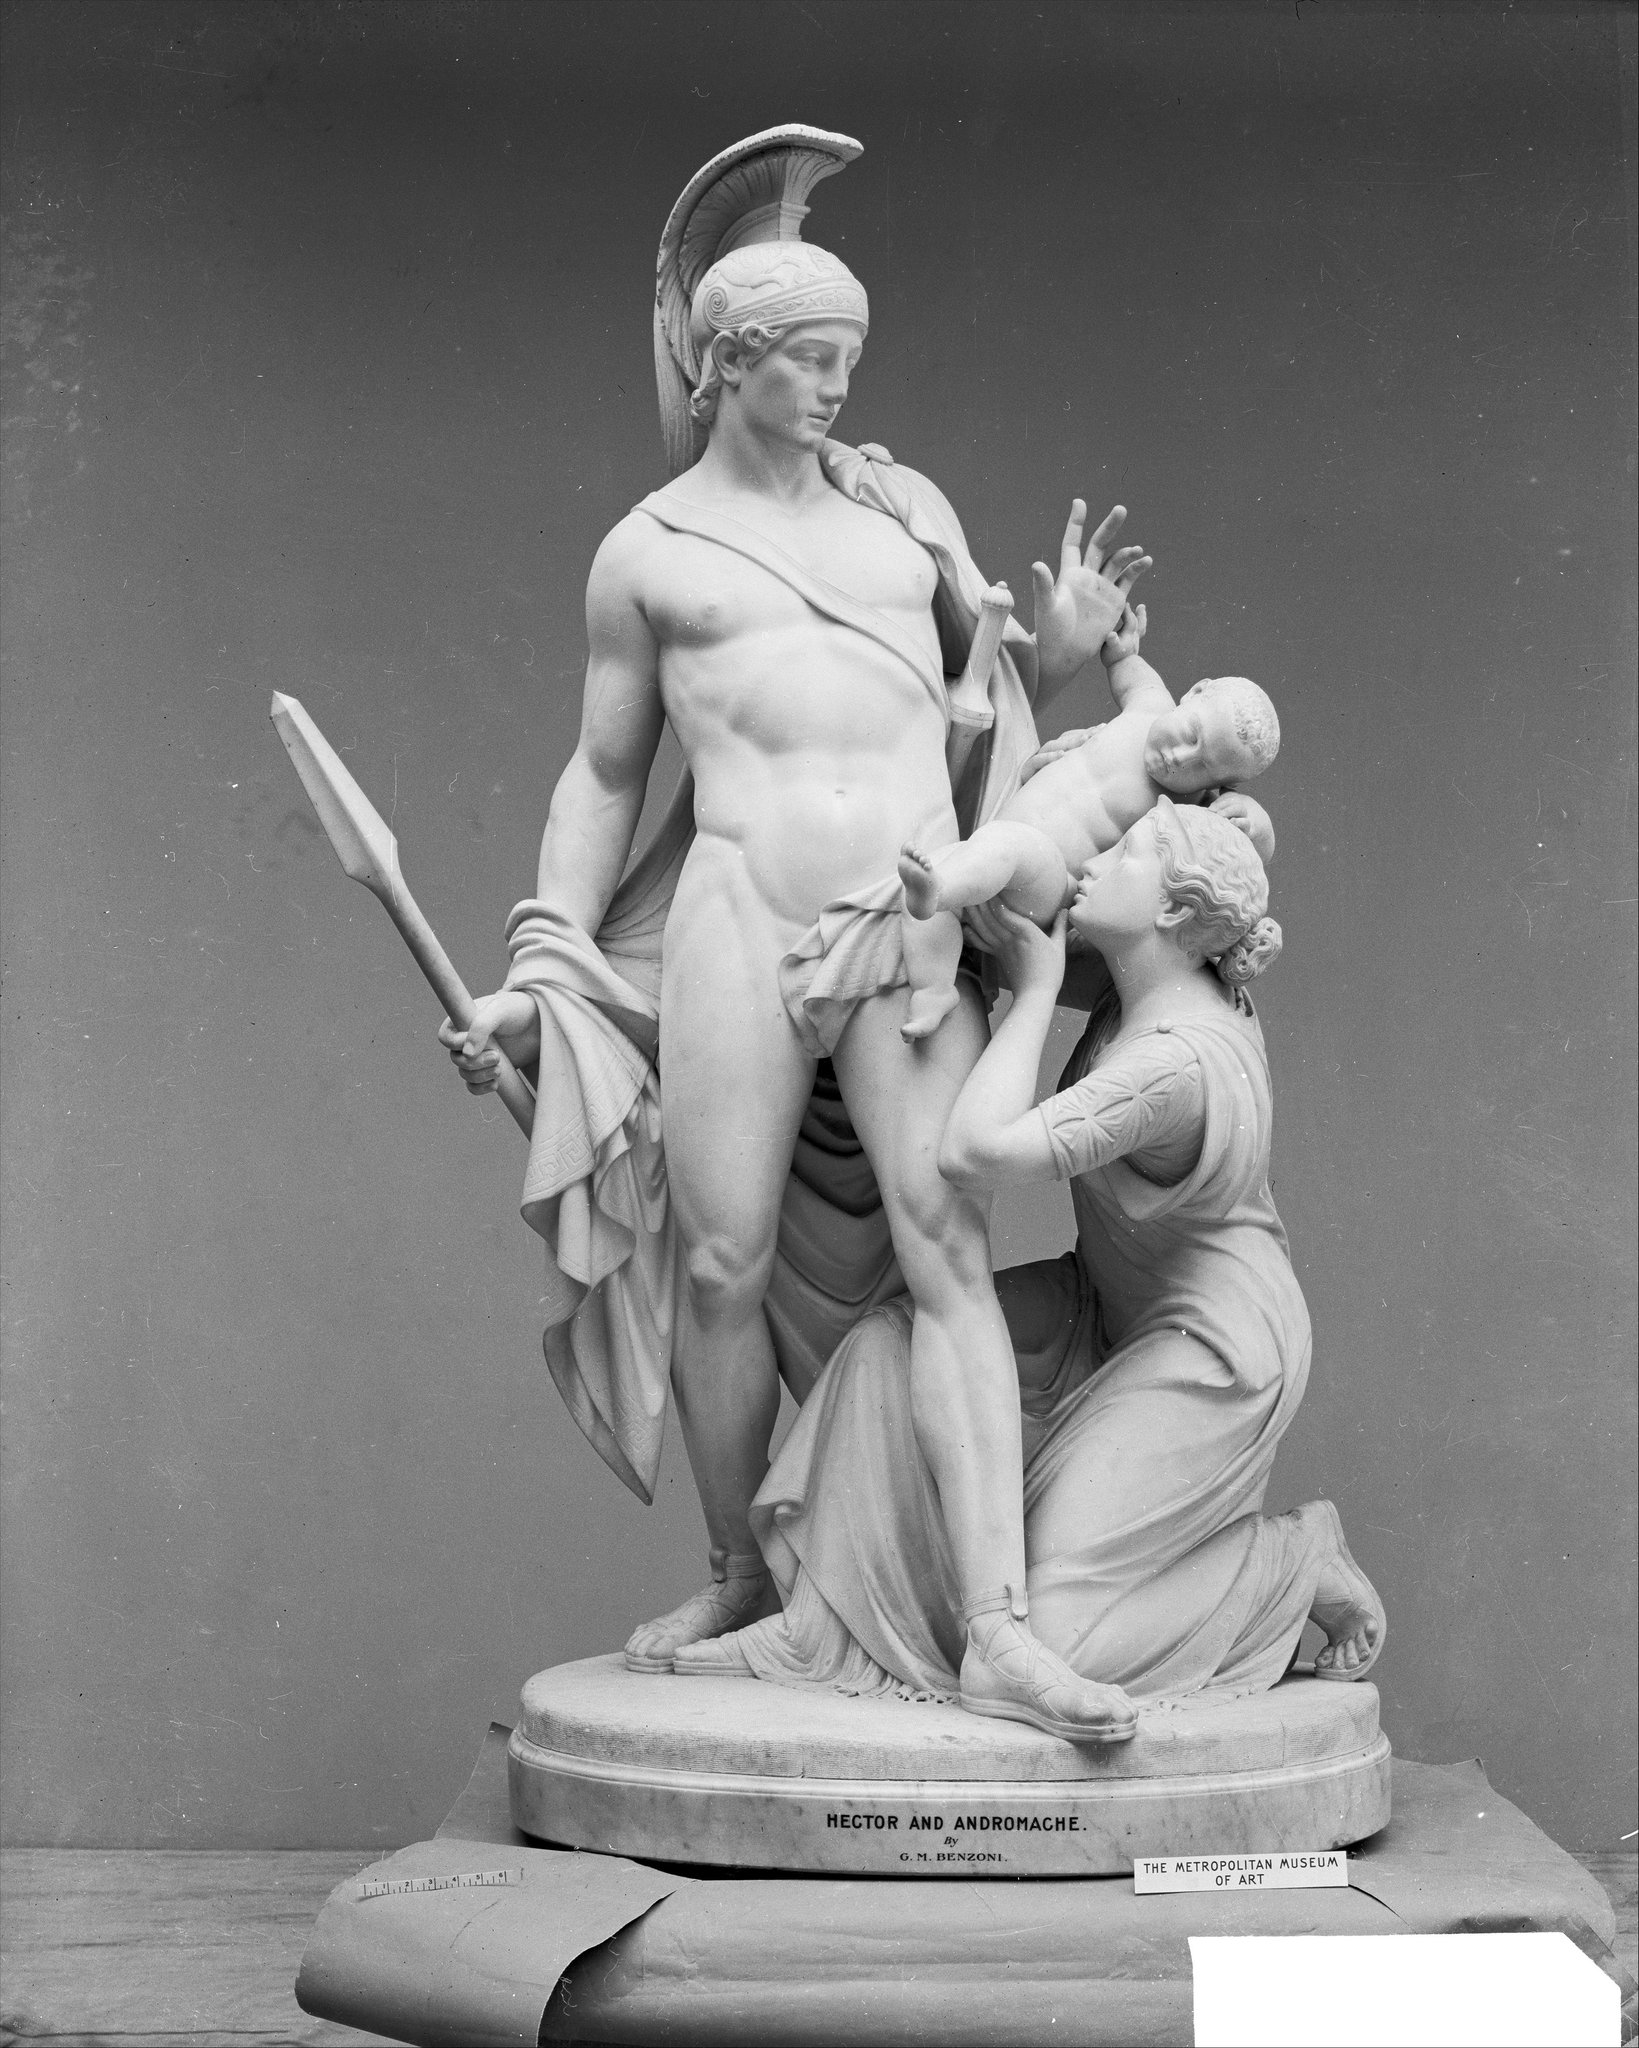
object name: group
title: Hector and Andromache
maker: giovanni maria benzoni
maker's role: artist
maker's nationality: italian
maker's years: 1809-1873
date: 1871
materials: marble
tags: spears,princes,infants,male nudes,women